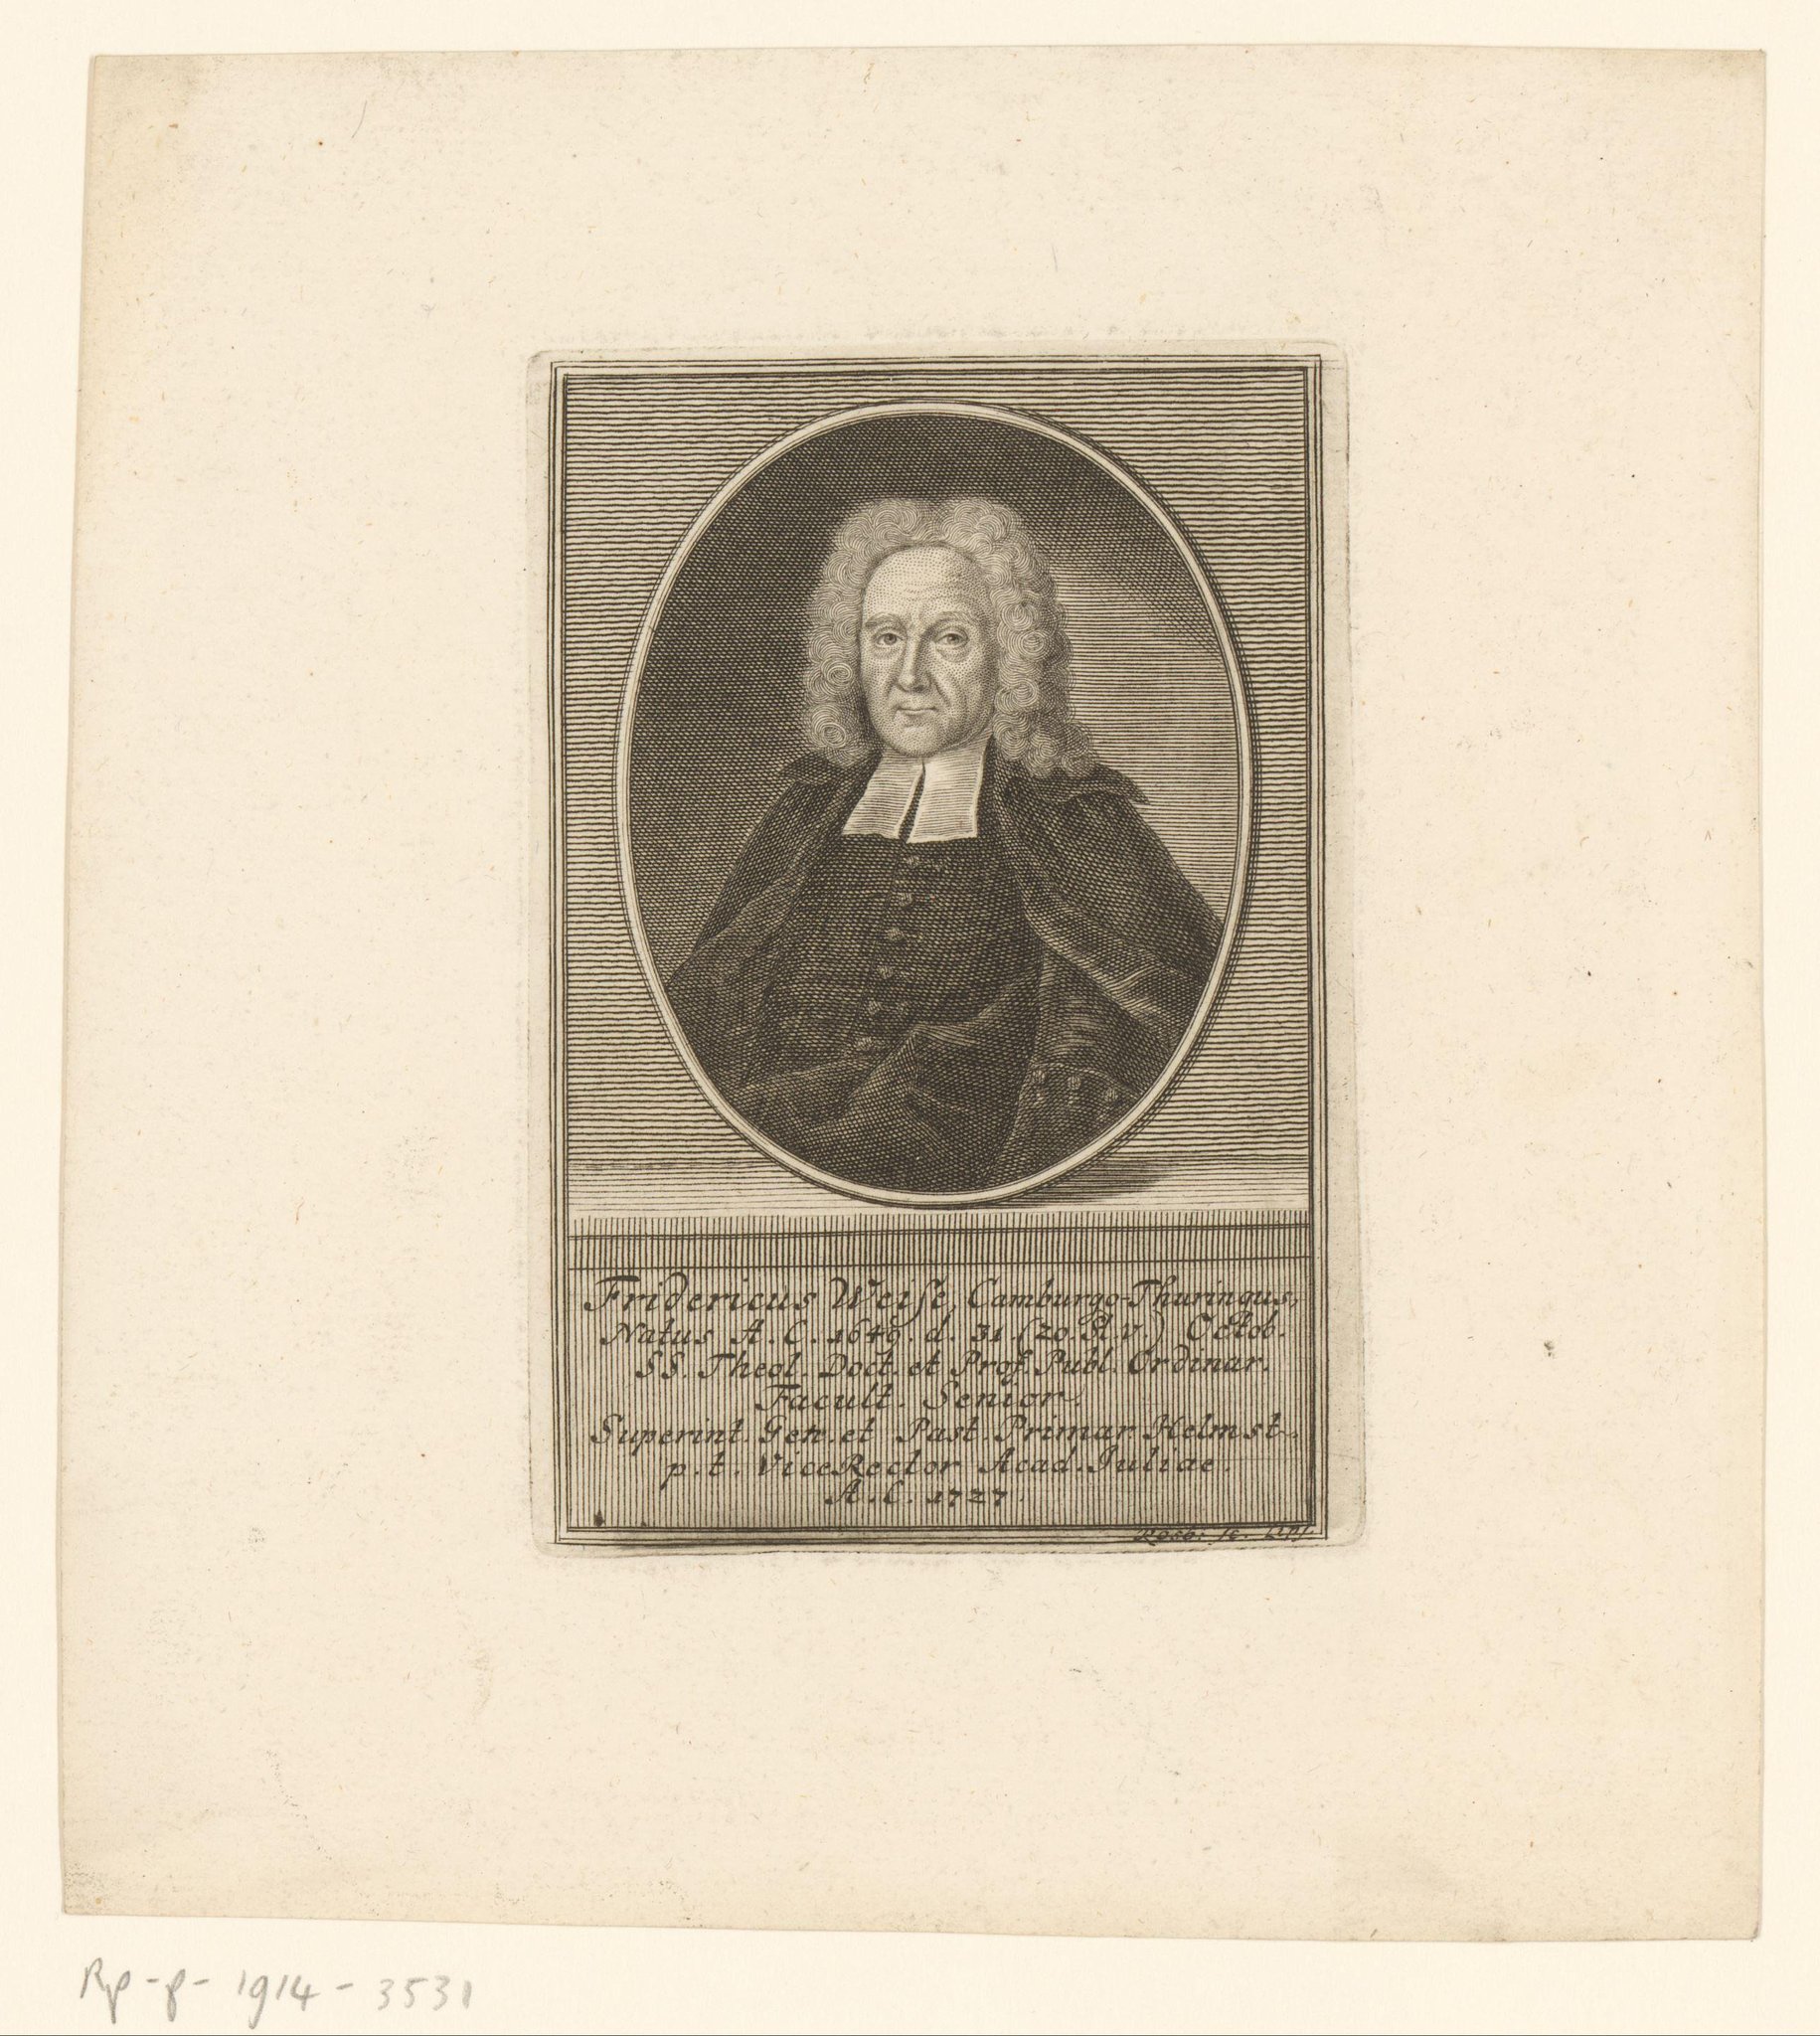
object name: print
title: Portret van Friedrich Weise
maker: johann friedrich rosbach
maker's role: print maker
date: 1727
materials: paper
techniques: engraving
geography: leipzig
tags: theologian, historical persons, wig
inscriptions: collector's mark: Lugt 2228